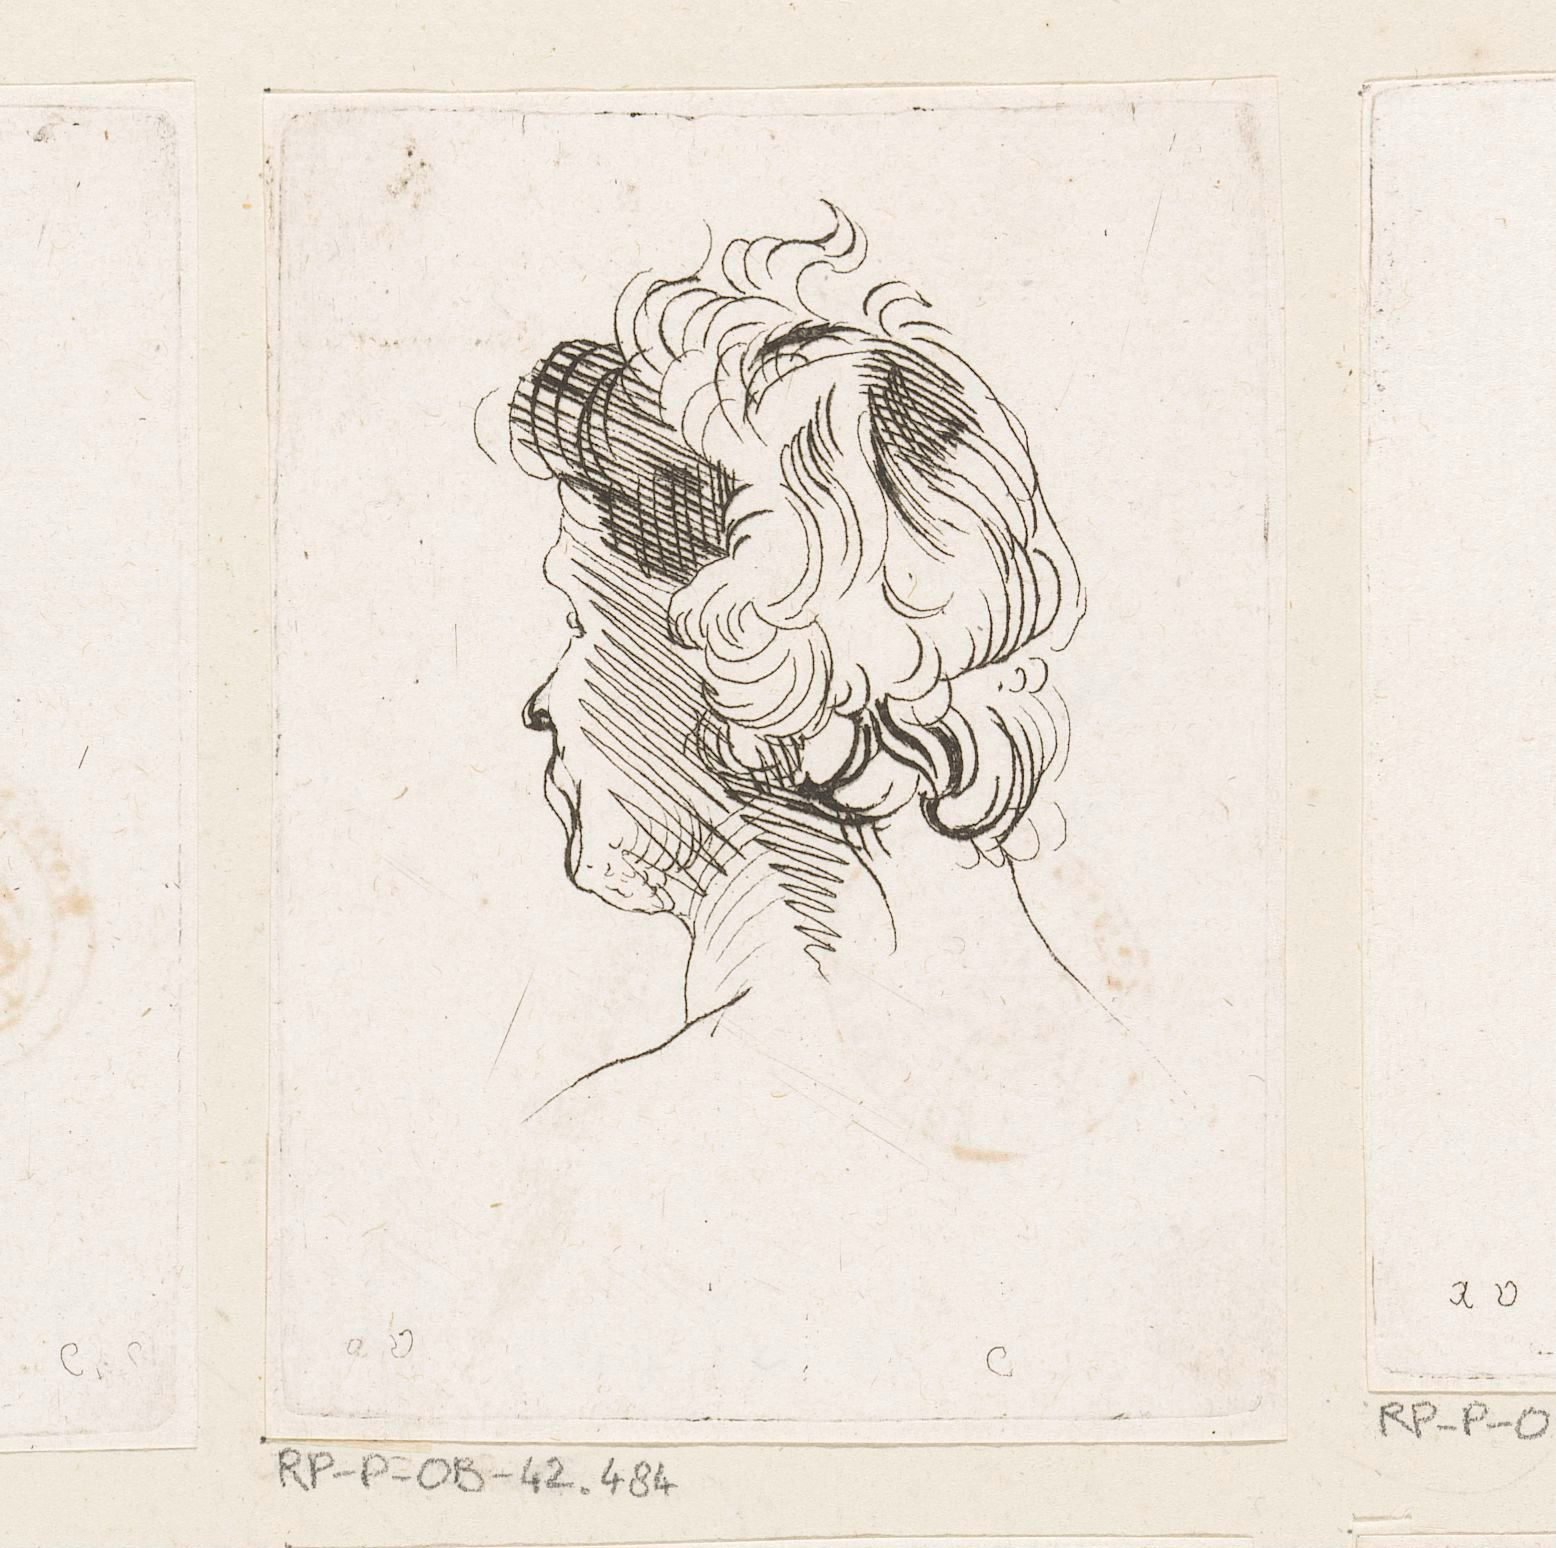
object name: print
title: Recueil de Testes d'Antoine Van Dyck (...)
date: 1735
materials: paper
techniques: etching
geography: france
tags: head (human), adult man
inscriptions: collector's mark: Lugt 240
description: Prent uit een serie van 31 prenten naar getekende hoofden door Van Dyck, plus een titelprent naar Bouchardon, getiteld: "Recueil de Testes d'Antoine Van Dyck tirées du Cabinet de M. Crozat et gravées par M. le C. de C.".